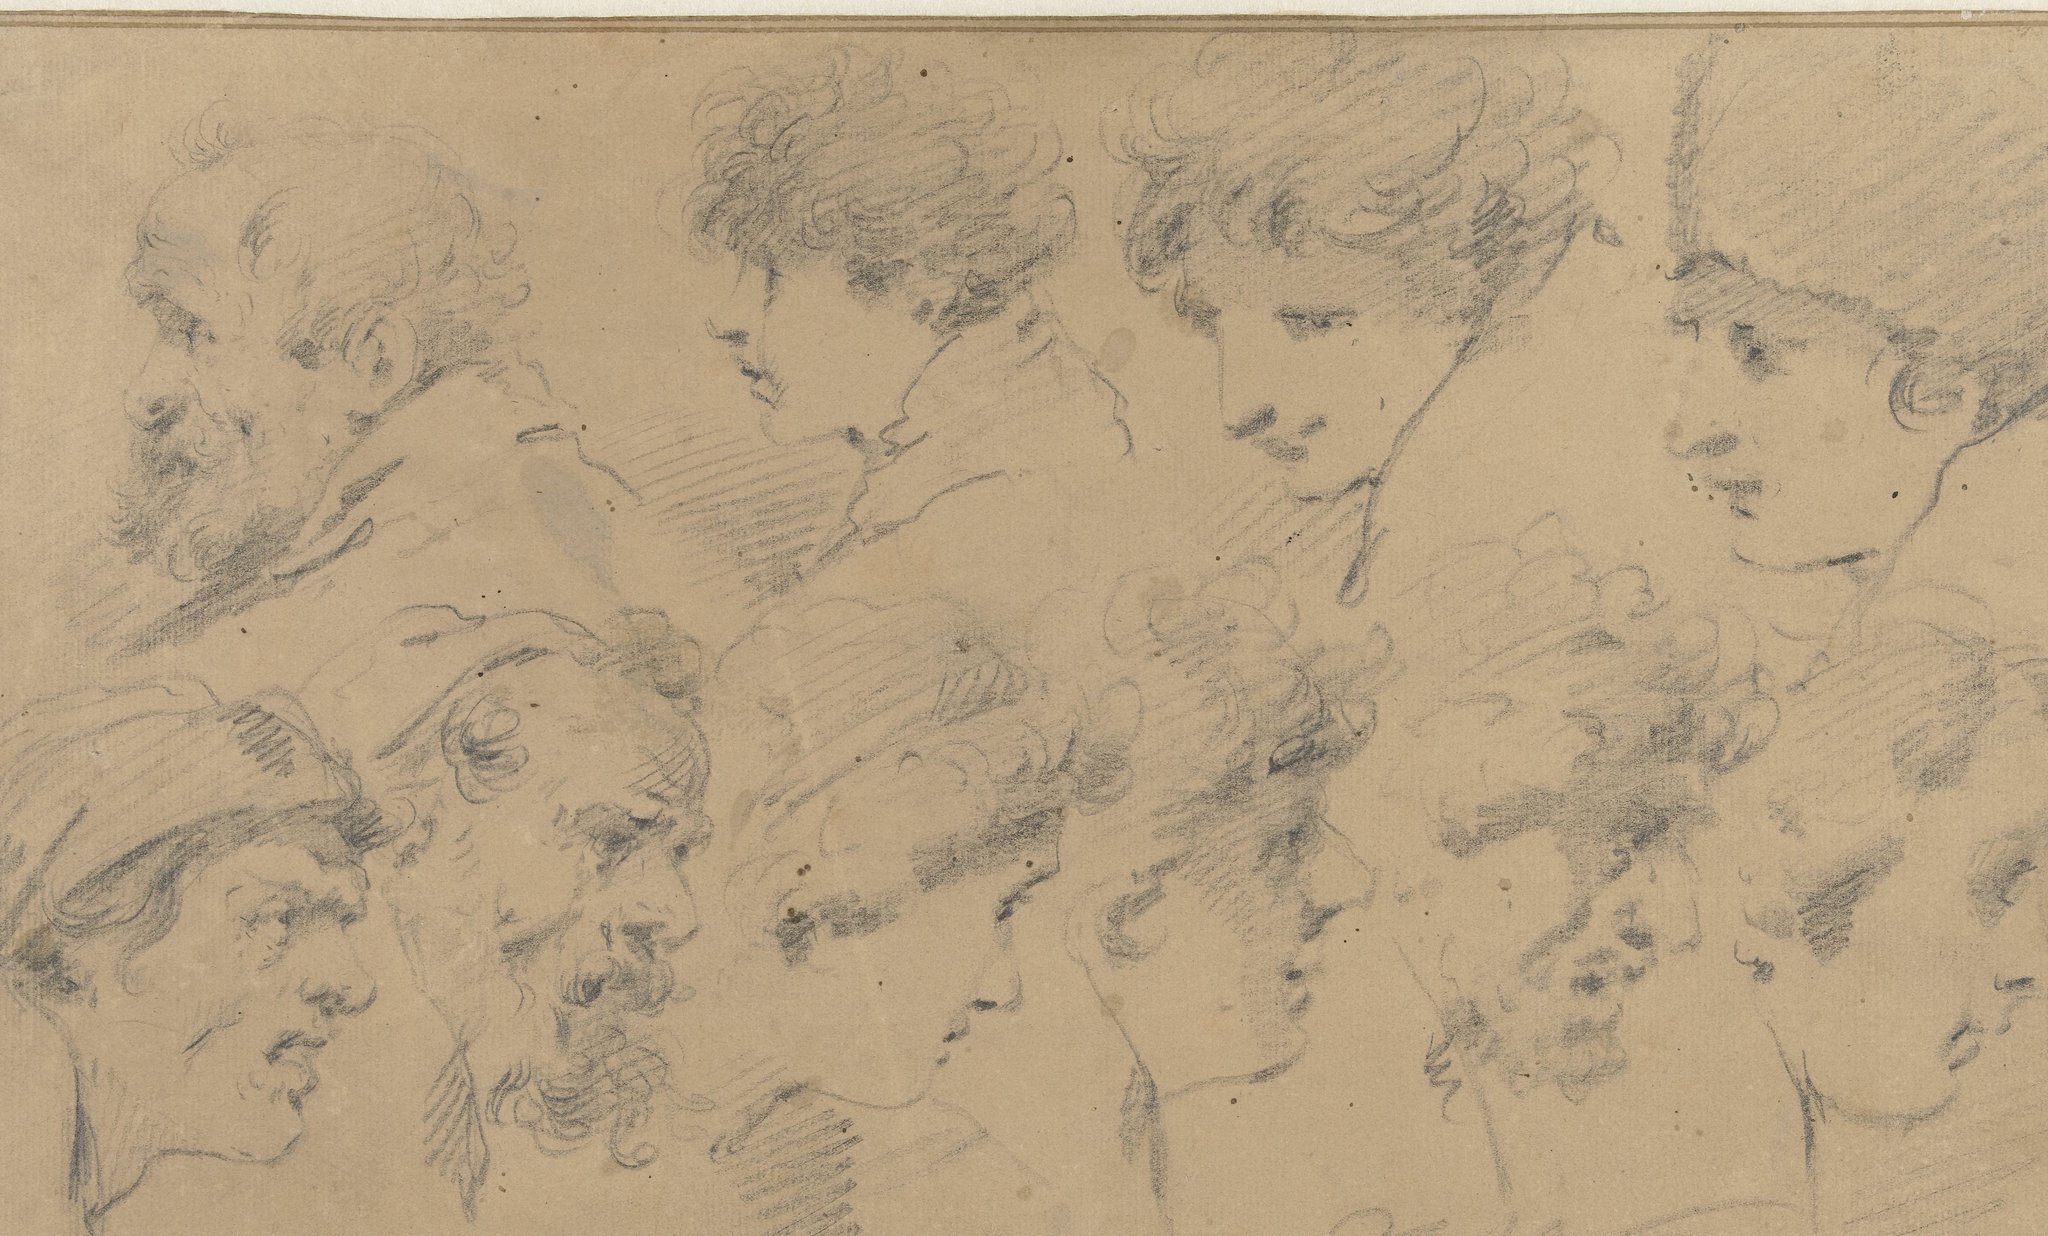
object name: drawing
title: Studieblad met tien koppen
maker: isaac walraven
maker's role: draughtsman, painter, print maker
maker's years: 1686-1765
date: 1744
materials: paper, pencil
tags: head (human)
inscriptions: signature and date: ‘JW 1744’